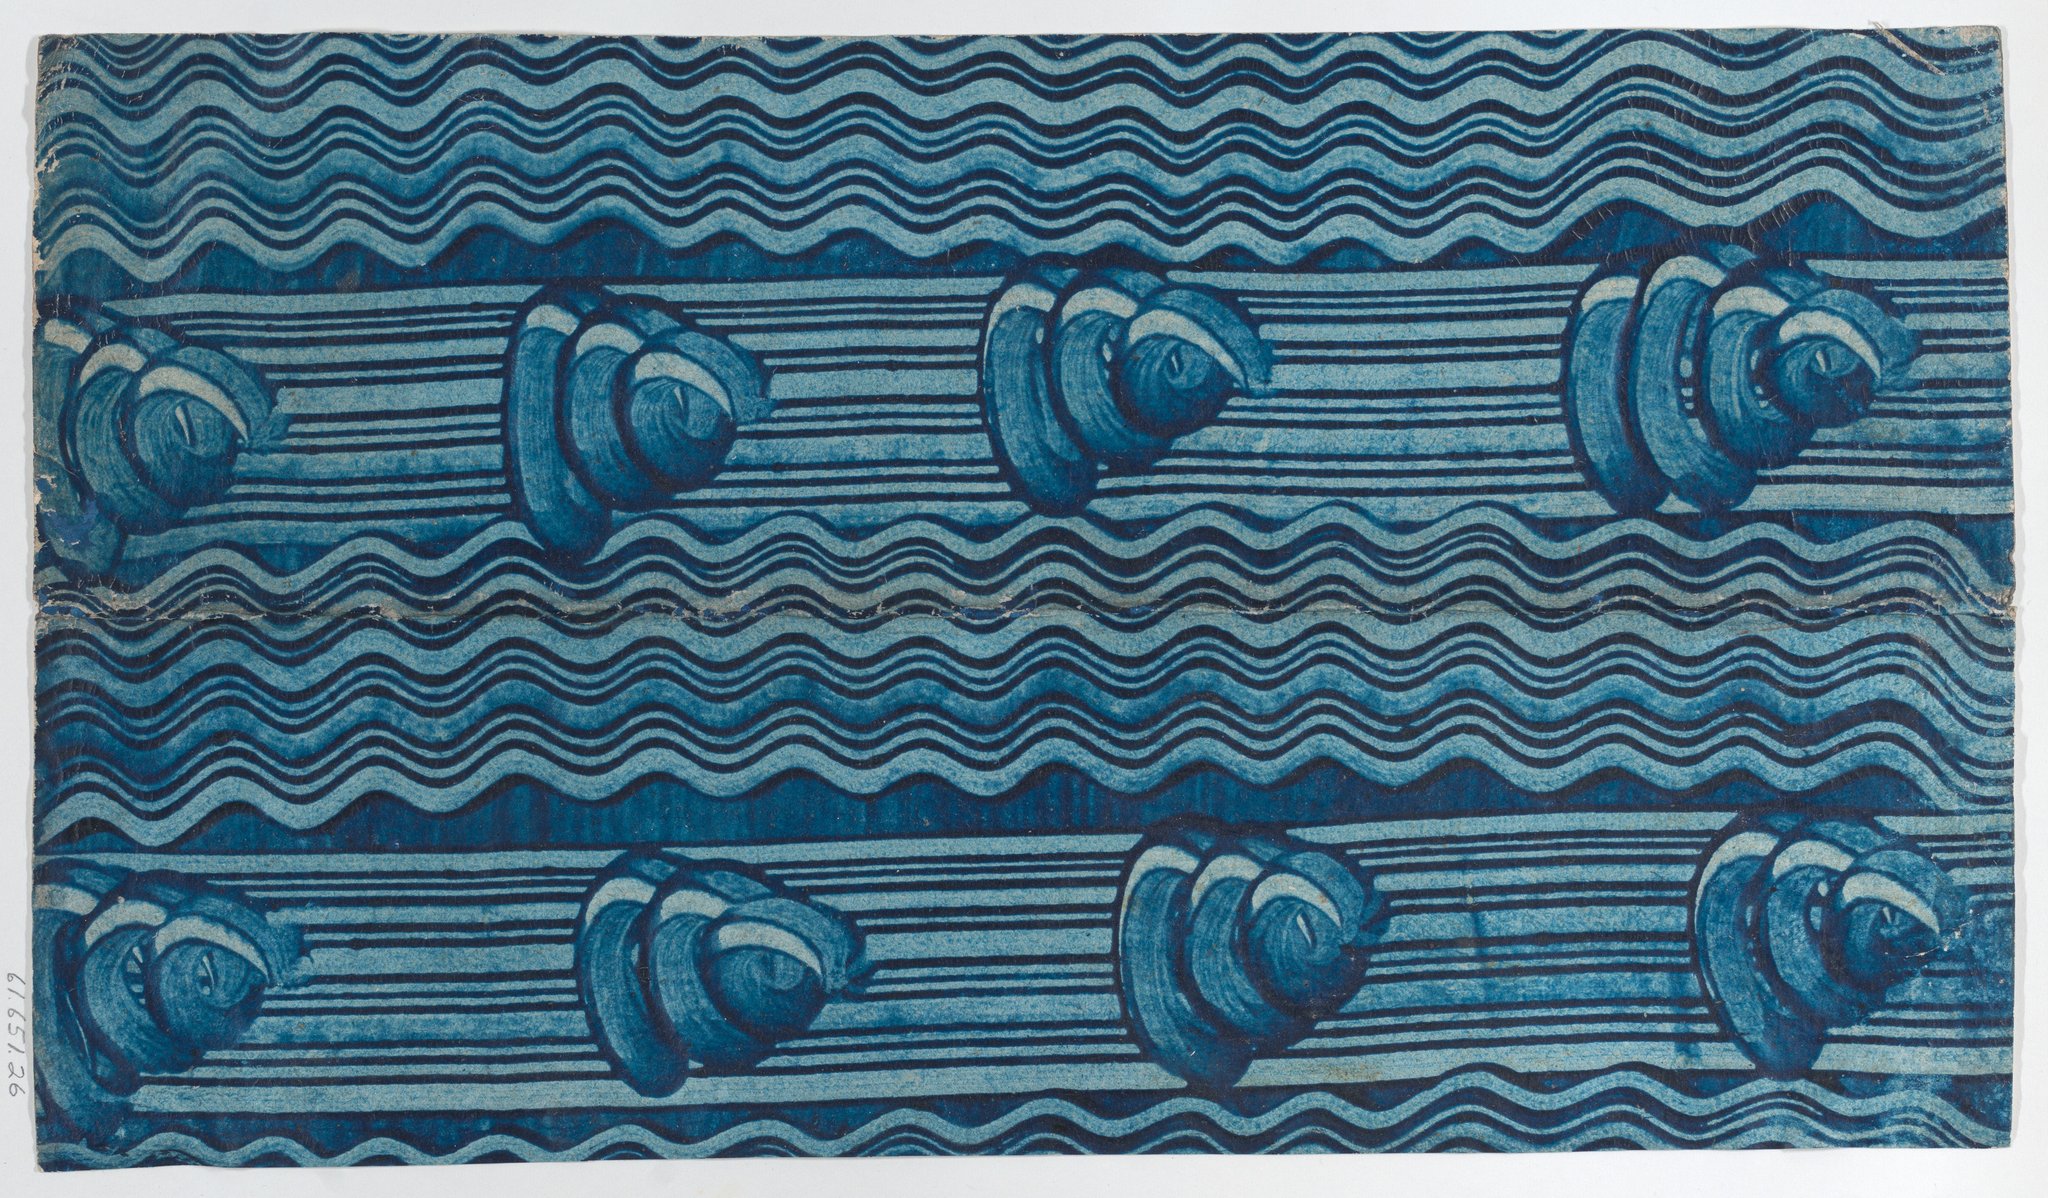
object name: print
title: Book cover with overall fruit and floral pattern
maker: Anonymous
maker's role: artist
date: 1801-1900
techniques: relief print